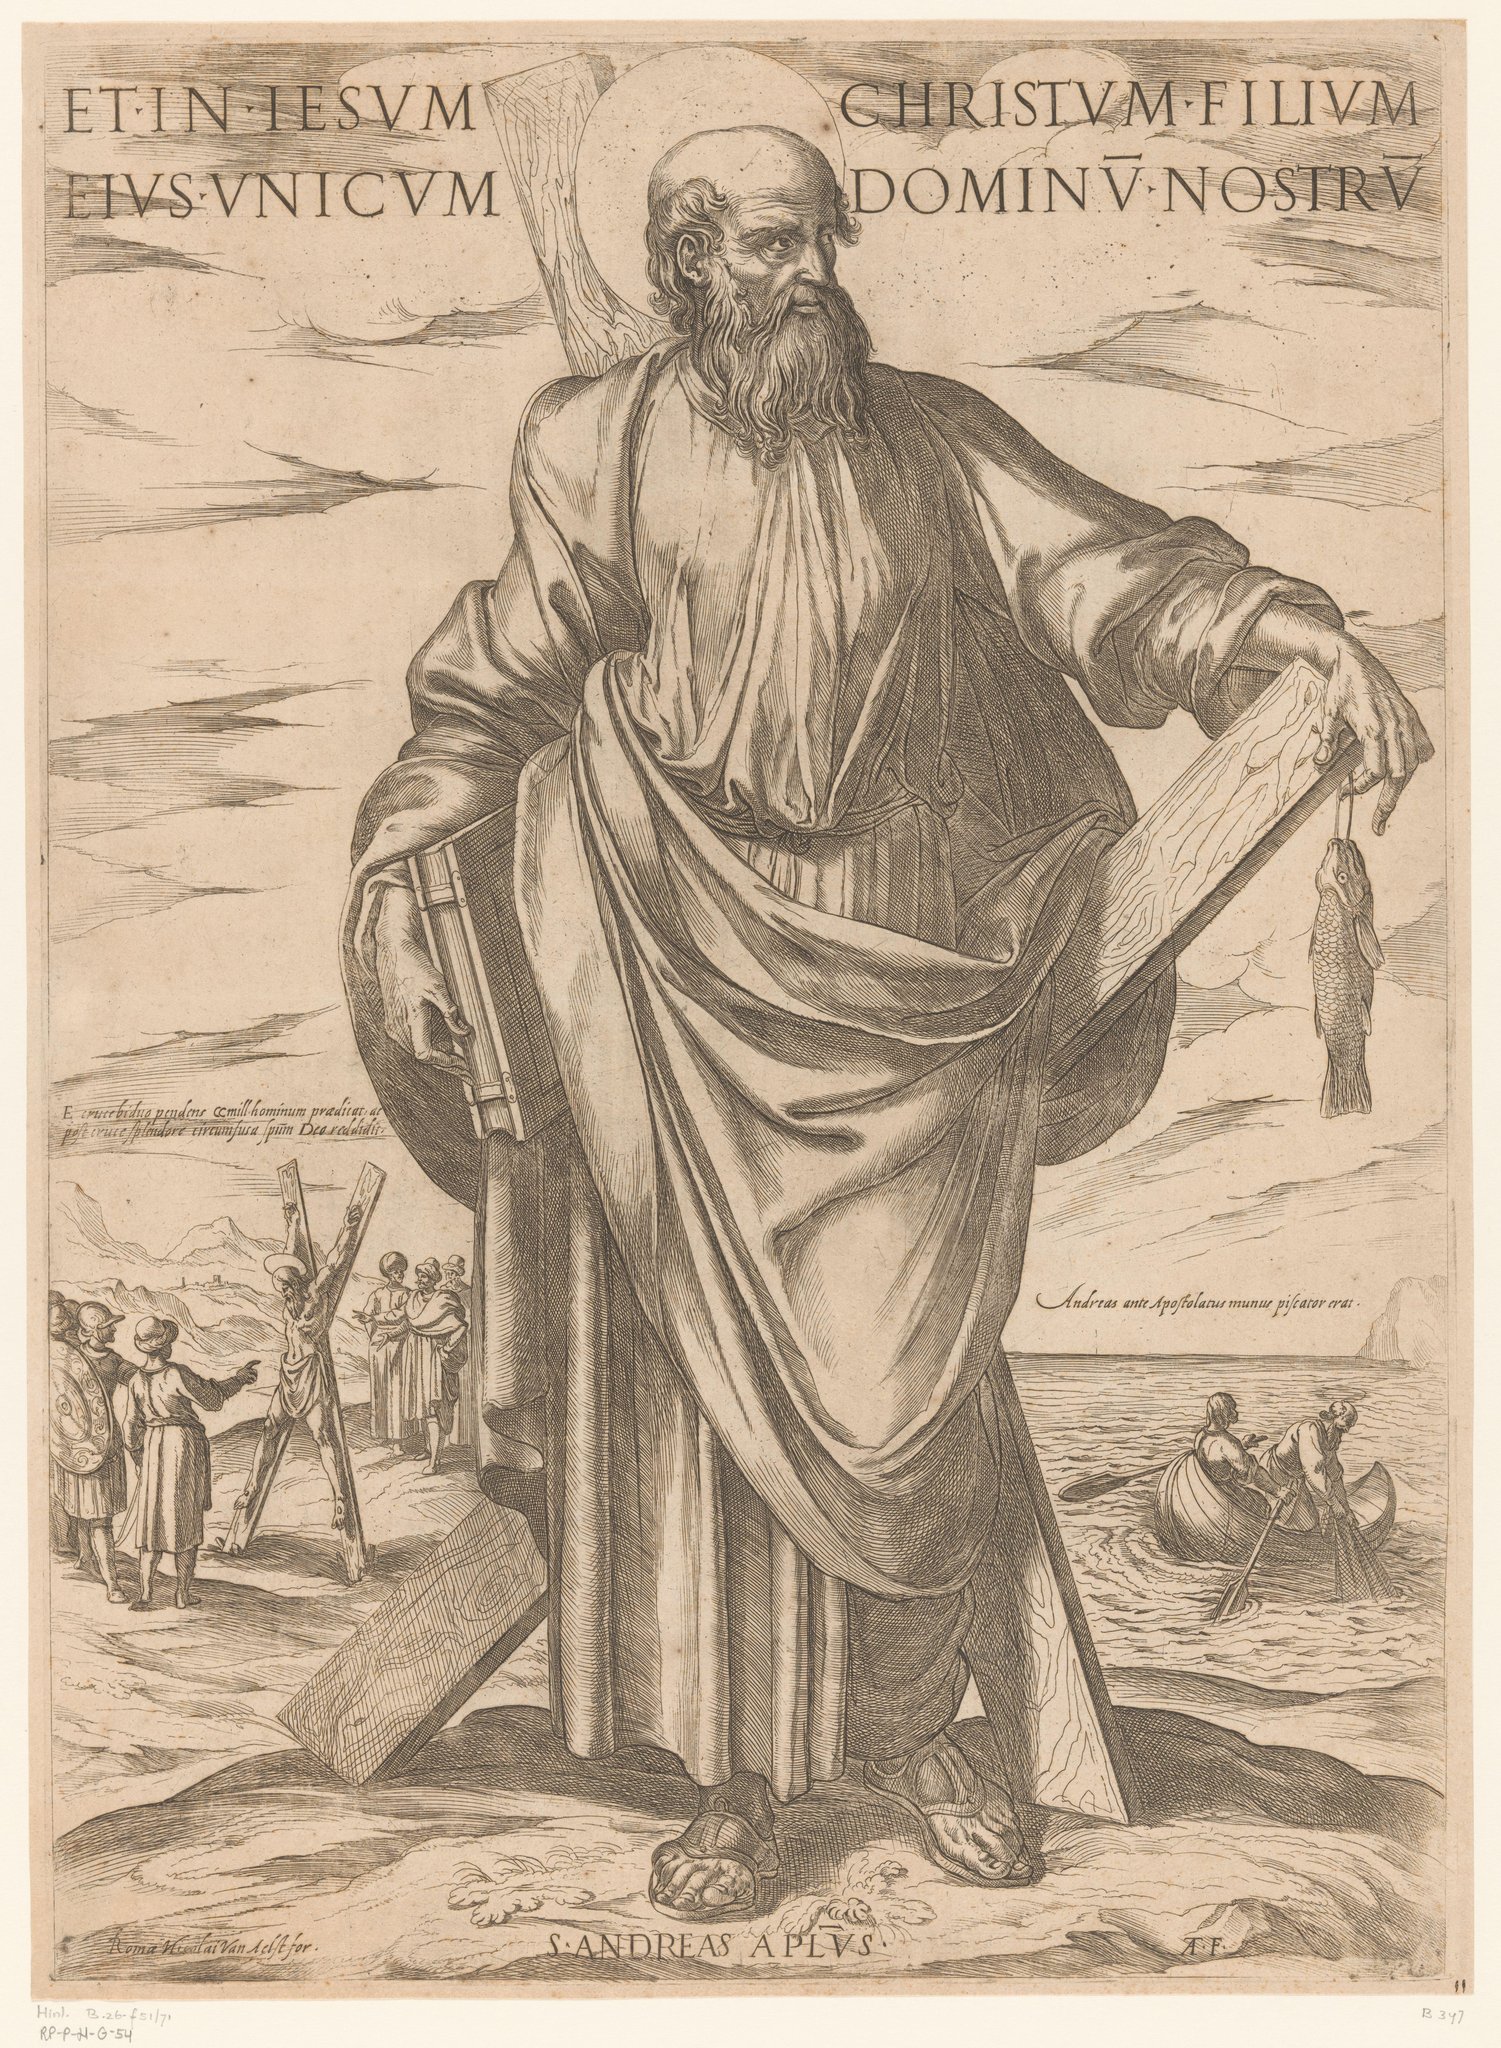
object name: print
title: Christus, Maria en de apostelen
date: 1565-1630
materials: paper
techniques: etching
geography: italy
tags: the apostle andrew; possible attributes: book, x-shaped cross, fish, fishing-net, rope, scroll, crucifixion of andrew: he is undressed and tied to the cross, calling of peter and andrew; they are called away from their fishing-boat (matthew 4:18-20; mark 1:16-18)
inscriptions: number: ‘11’, collector's mark: ‘Hinloopen’, collector's mark: Lugt 11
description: De heilige Andreas met boek, vis en Andreaskruis. Op de achtergrond rechts de heilige Andreas vissend in een boot op zee. Op de achtergrond links de kruisiging van de heilige Andreas.